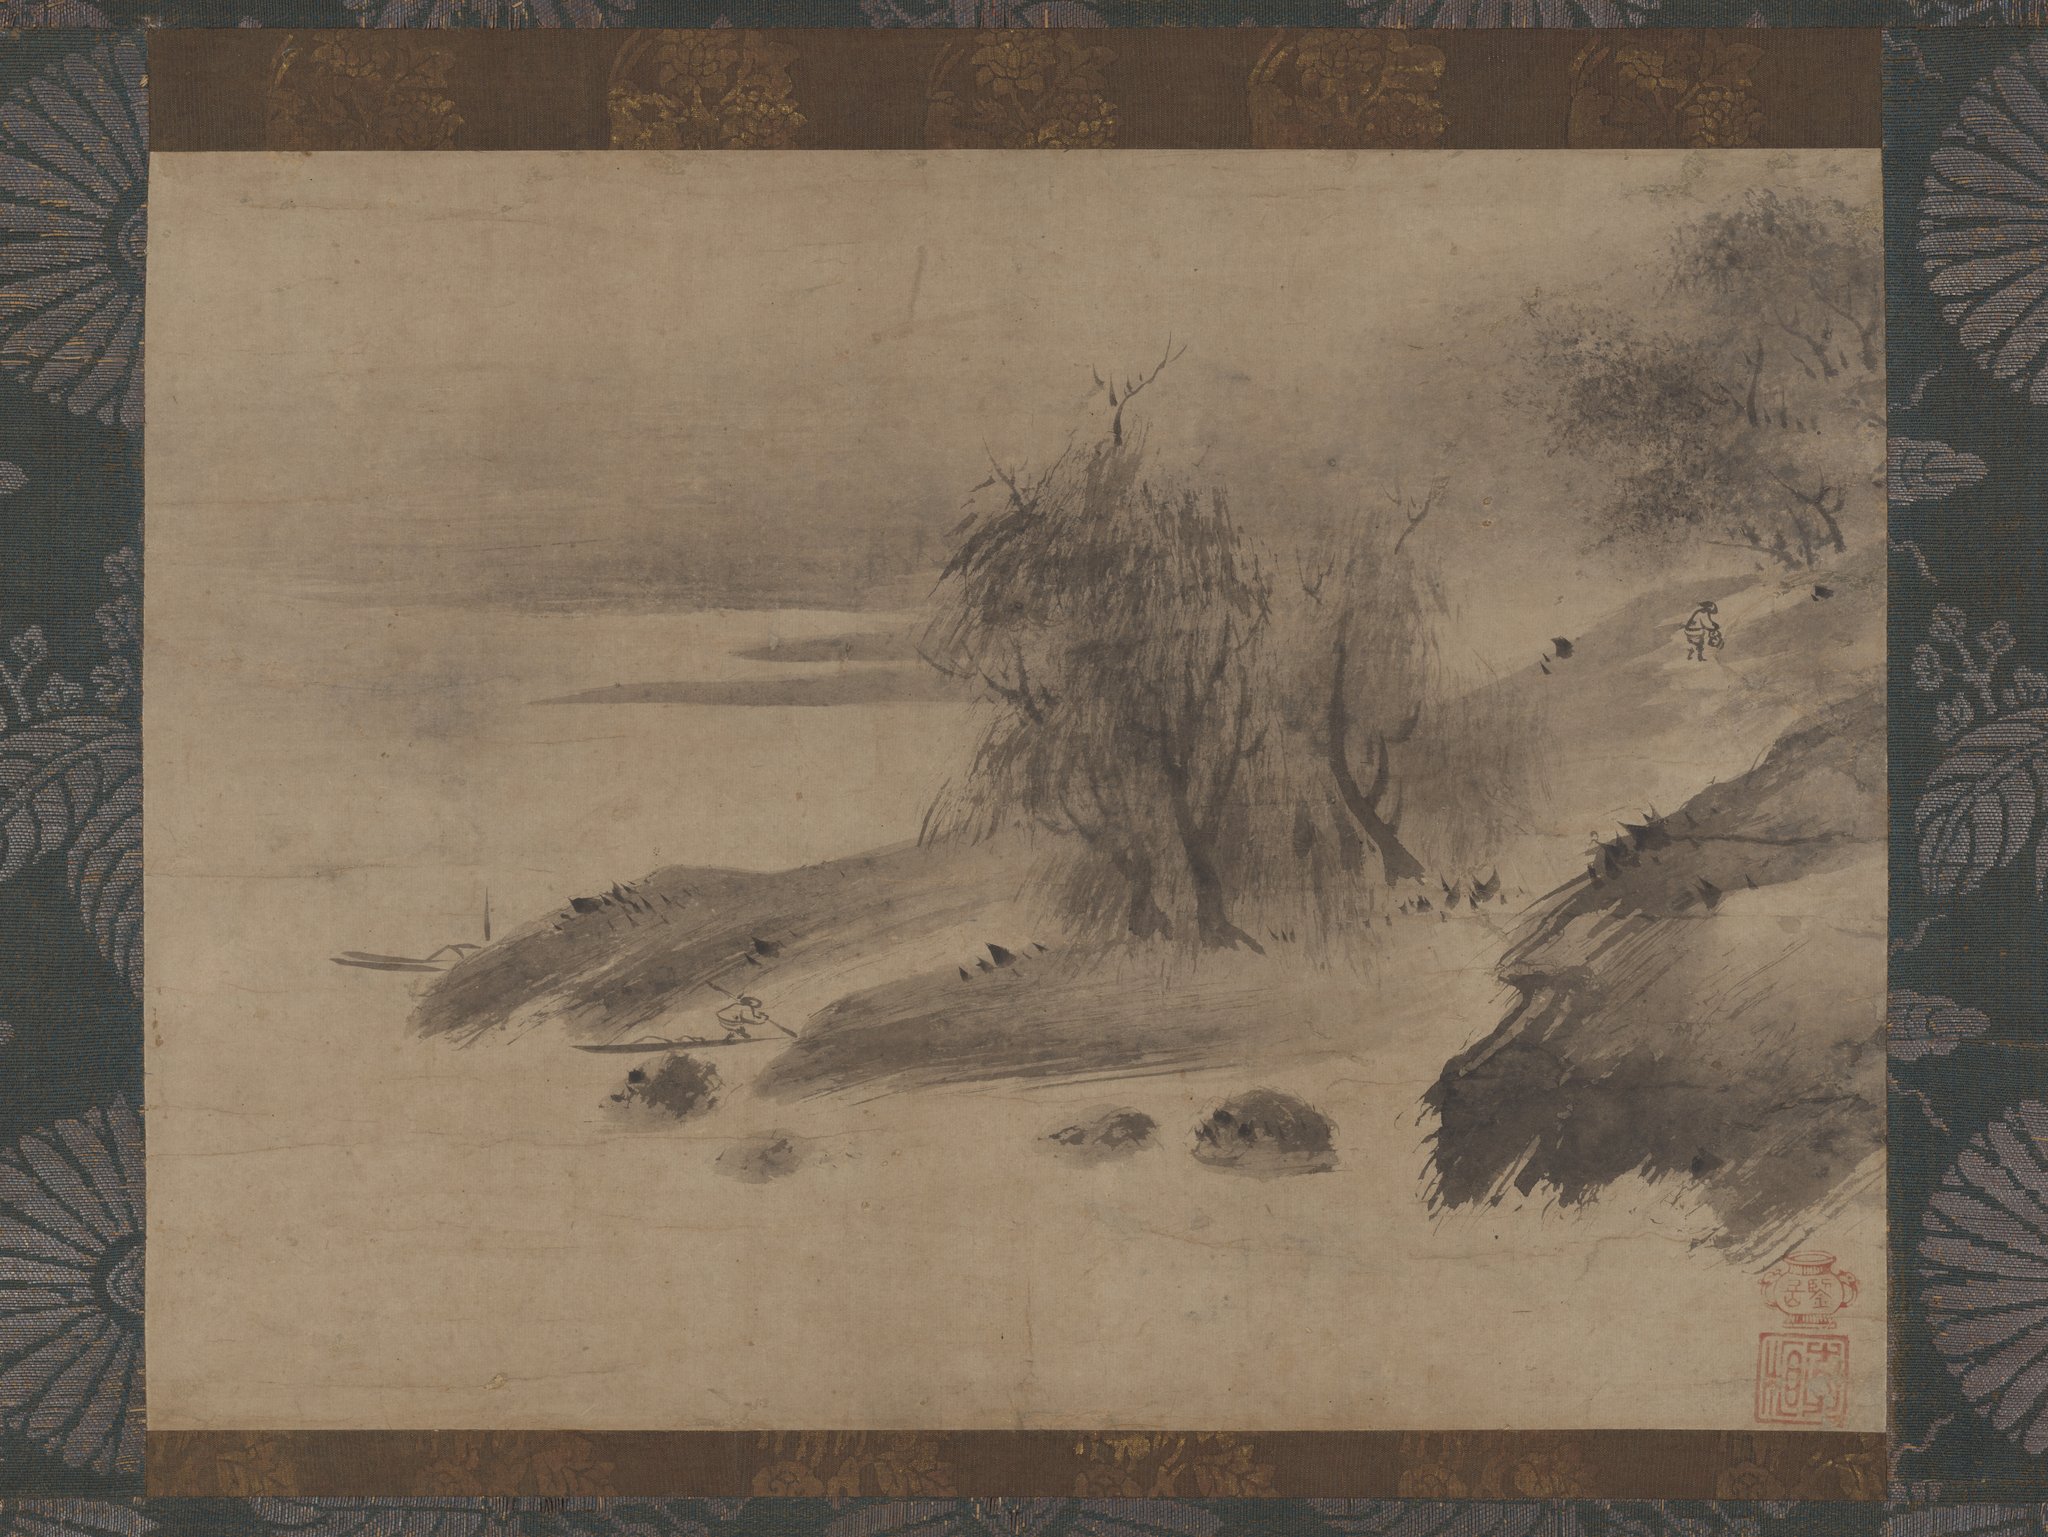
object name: hanging scroll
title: Landscape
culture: japanese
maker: sōami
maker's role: artist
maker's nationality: japanese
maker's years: 1485-1525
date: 1401-1533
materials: ink, paper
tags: landscapes